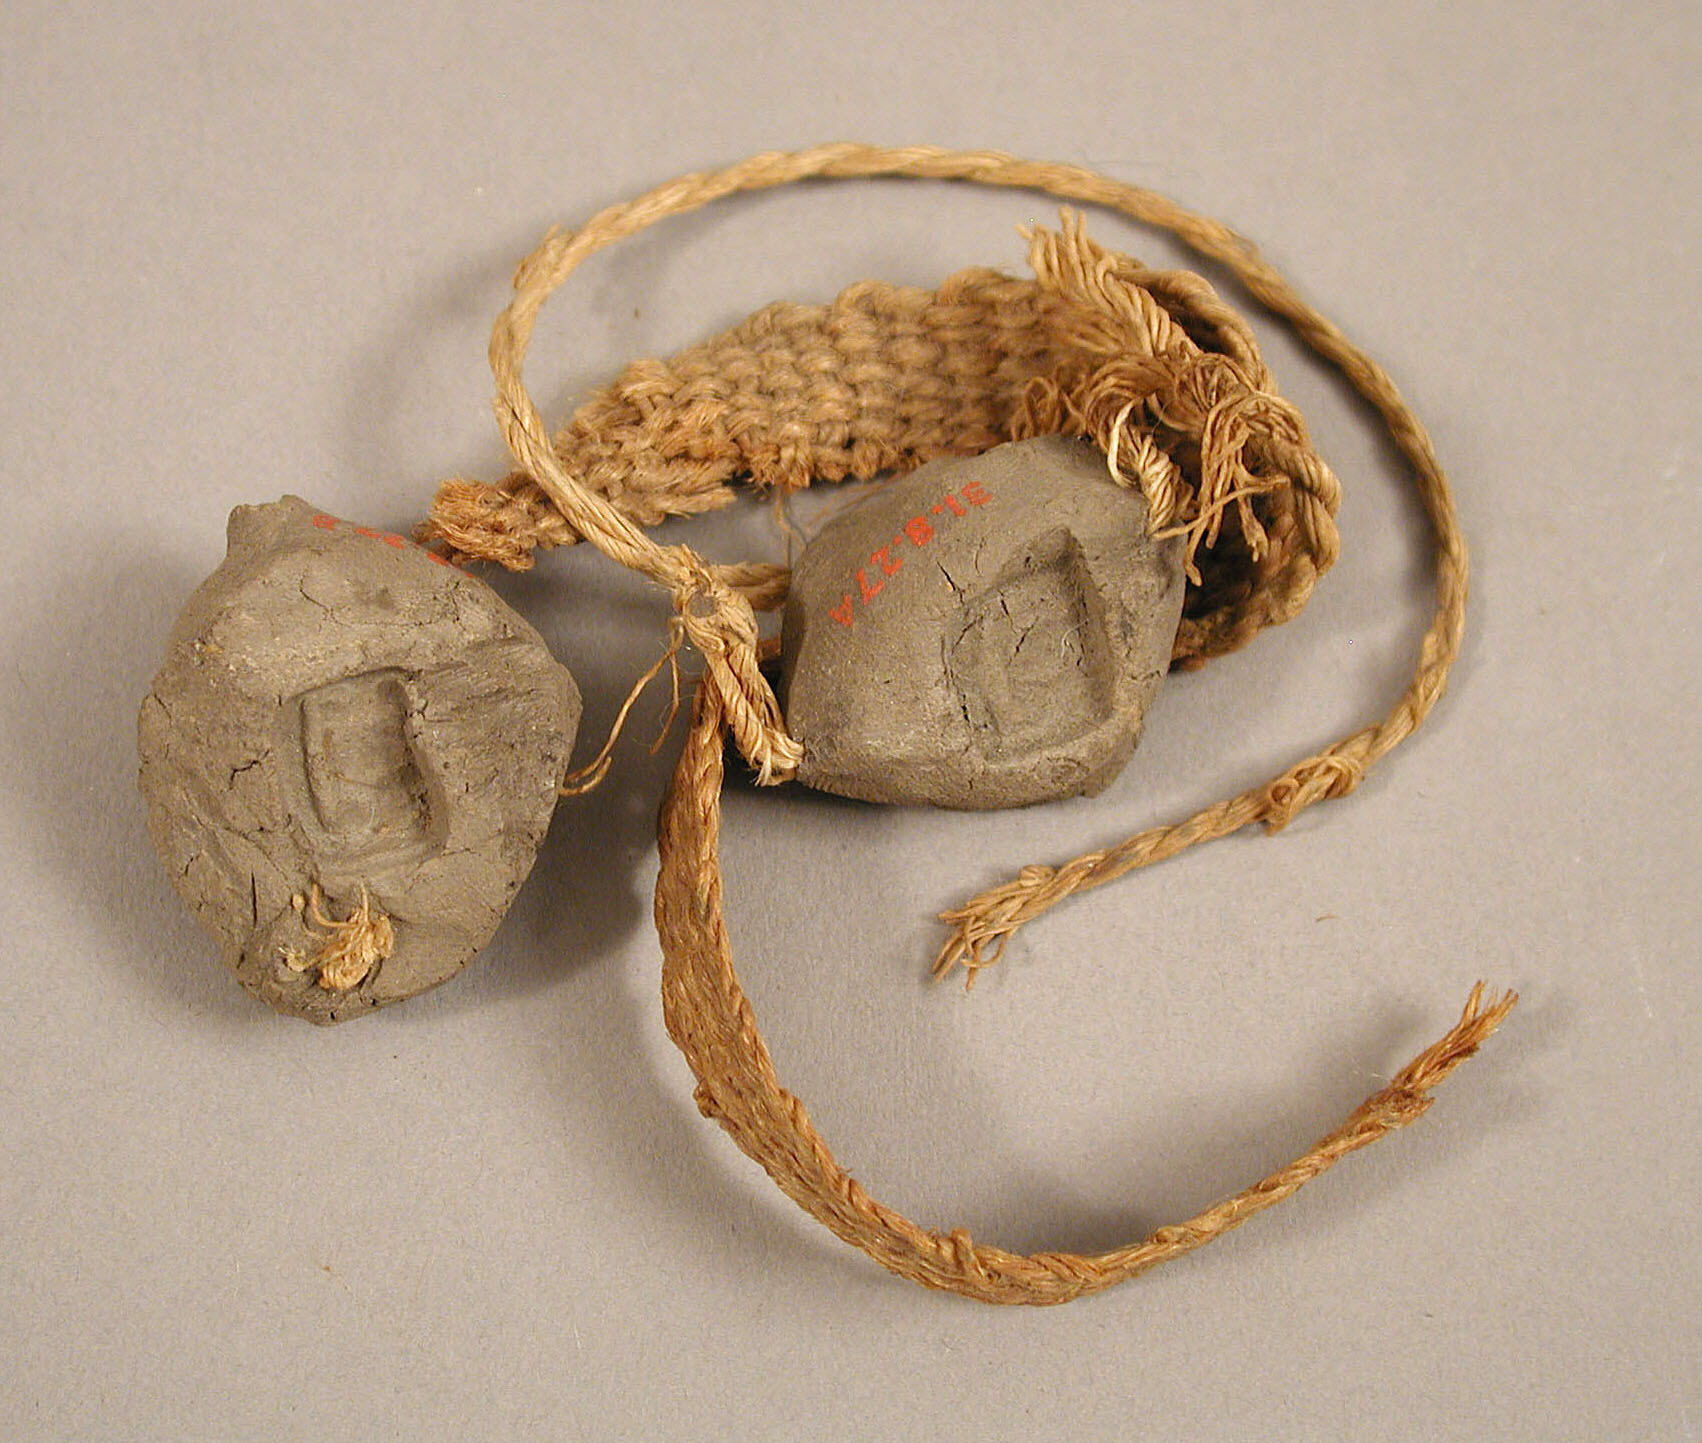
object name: seal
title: Two Seals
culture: coptic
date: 301-400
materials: mud, textile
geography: egypt